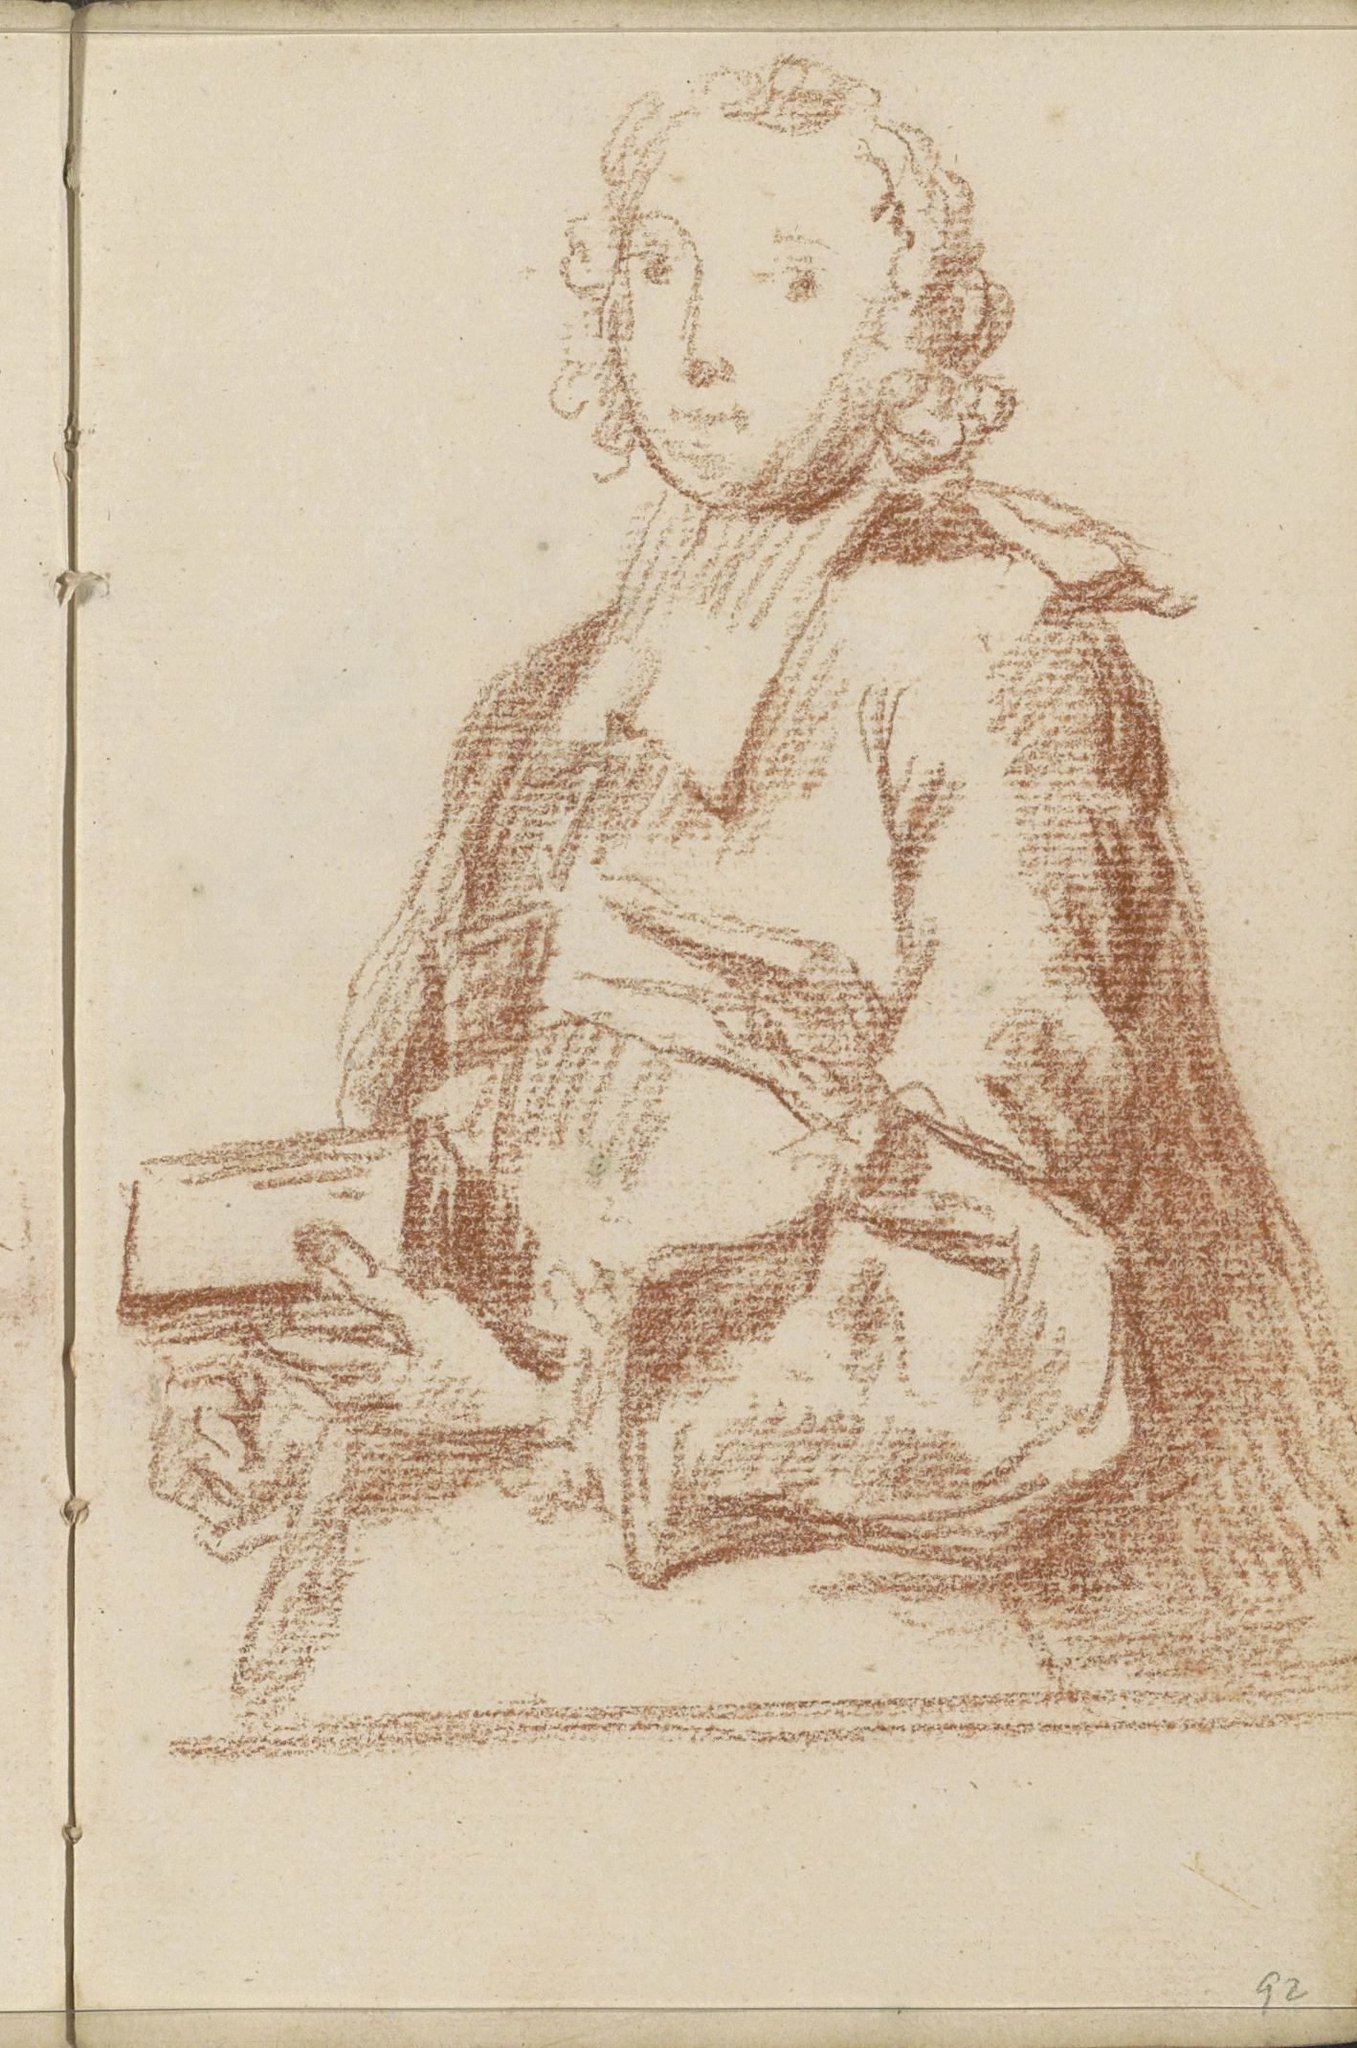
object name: sketchbook leaf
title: Staande man met boek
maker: petrus johannes van reysschoot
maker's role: draughtsman, print maker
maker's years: 1702-1772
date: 1710-1772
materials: chalk, paper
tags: standing figure, book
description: Blad 92 recto uit een schetsboek met 105 bladen.